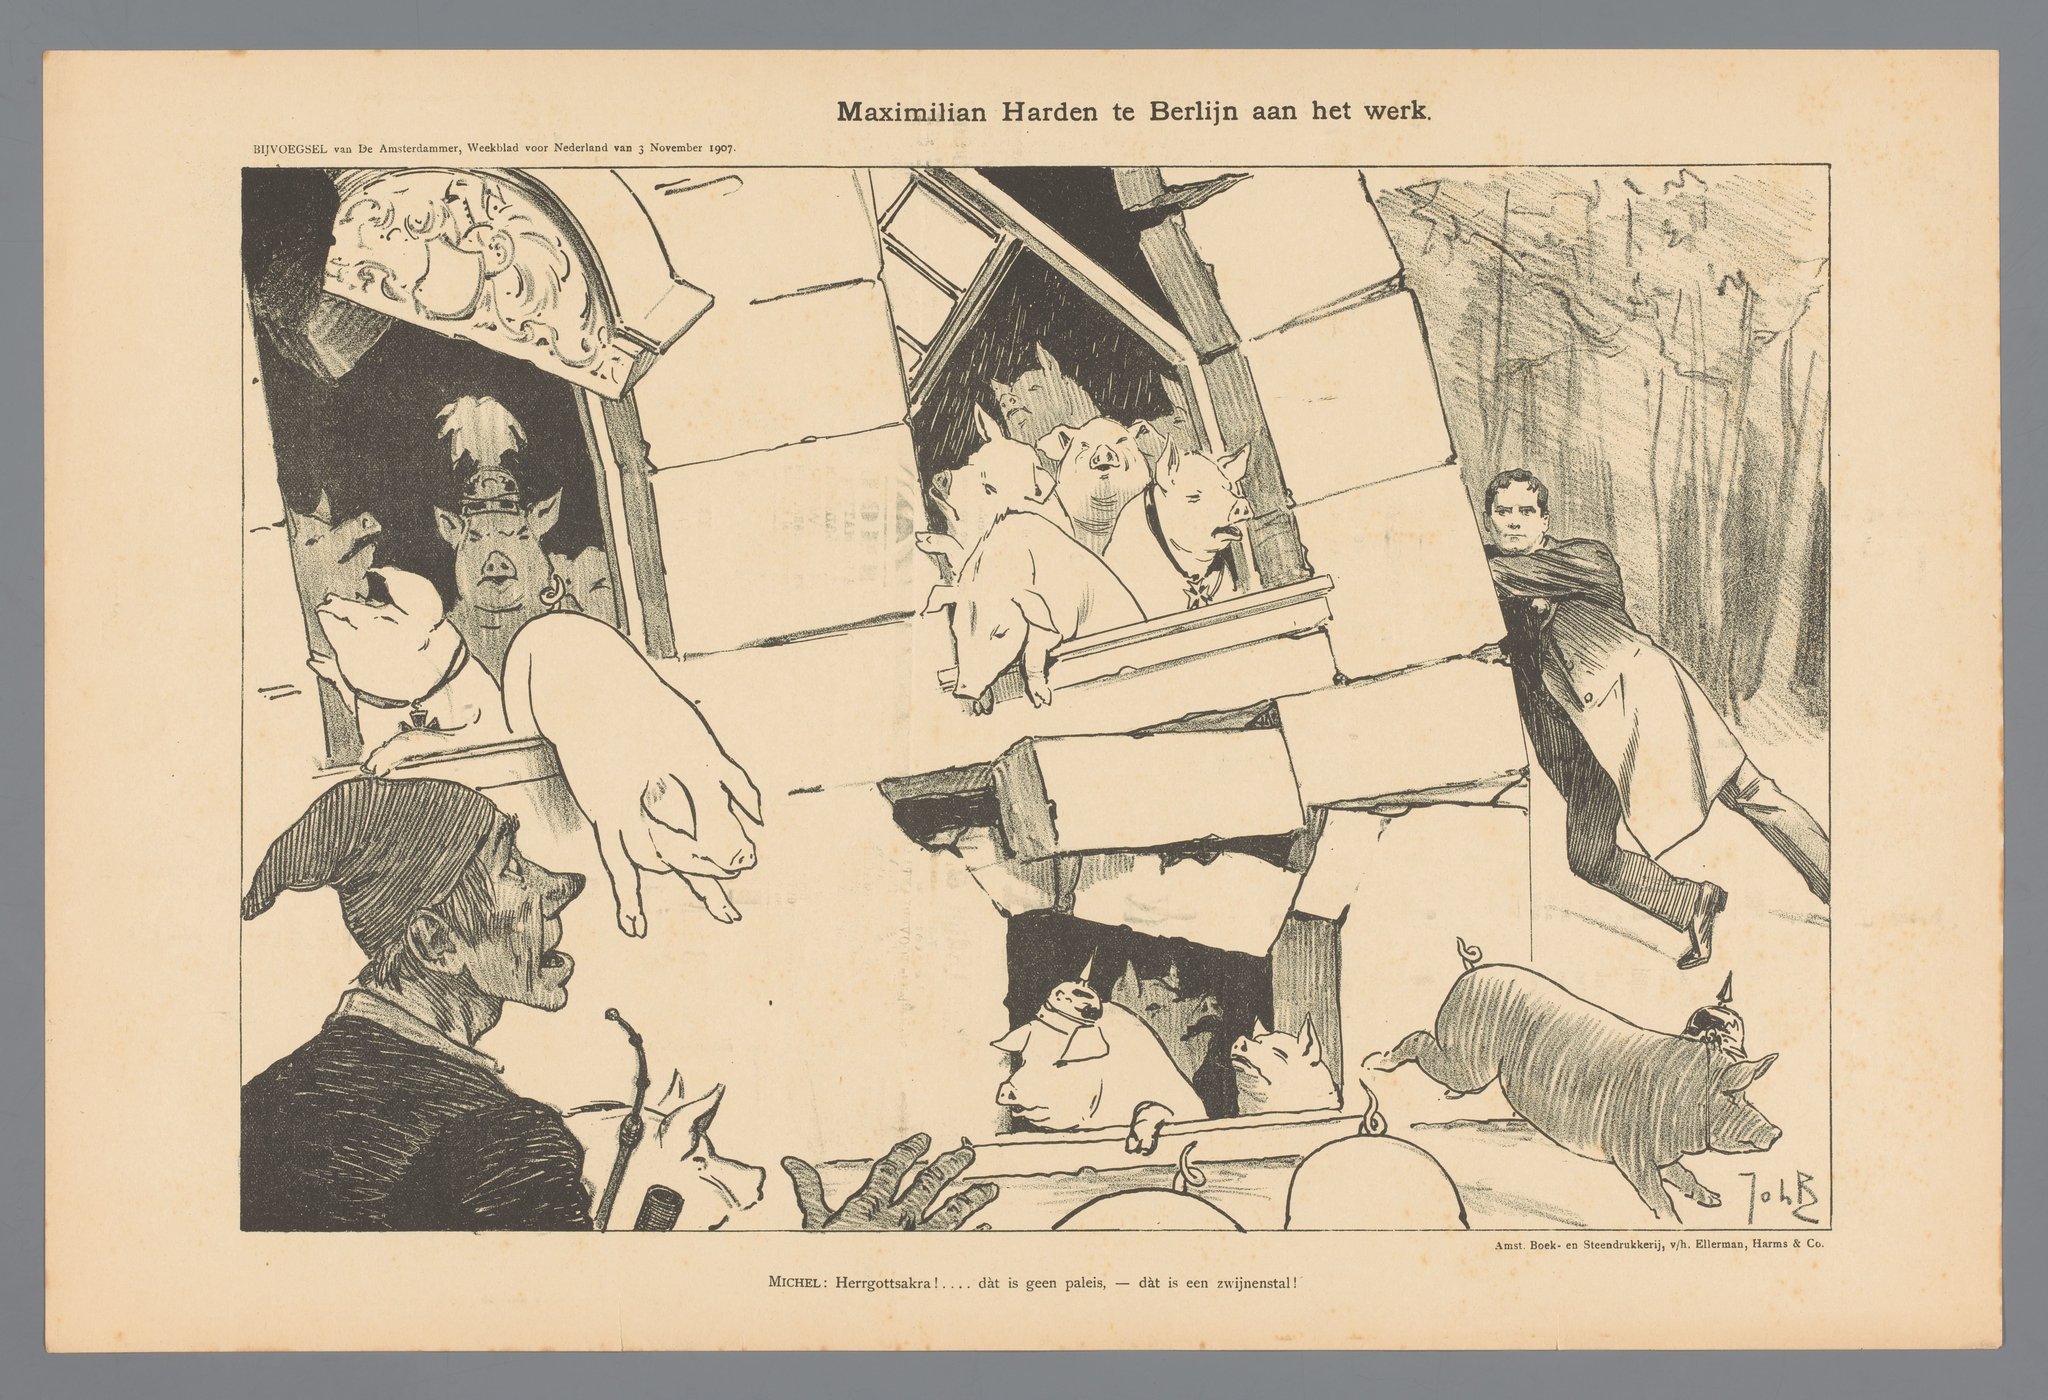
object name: cartoon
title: Maximilian Harden te Berlijn aan het werk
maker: johan braakensiek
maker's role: draughtsman, print maker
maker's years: 1858-1940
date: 1907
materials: paper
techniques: lithograph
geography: amsterdam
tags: wilhelm ii (keizer van duitsland), pig, political caricatures and satires, germany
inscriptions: date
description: Prent uit het bijvoegsel van: De Amsterdammer. Weekblad voor Nederland, 3 november 1907.